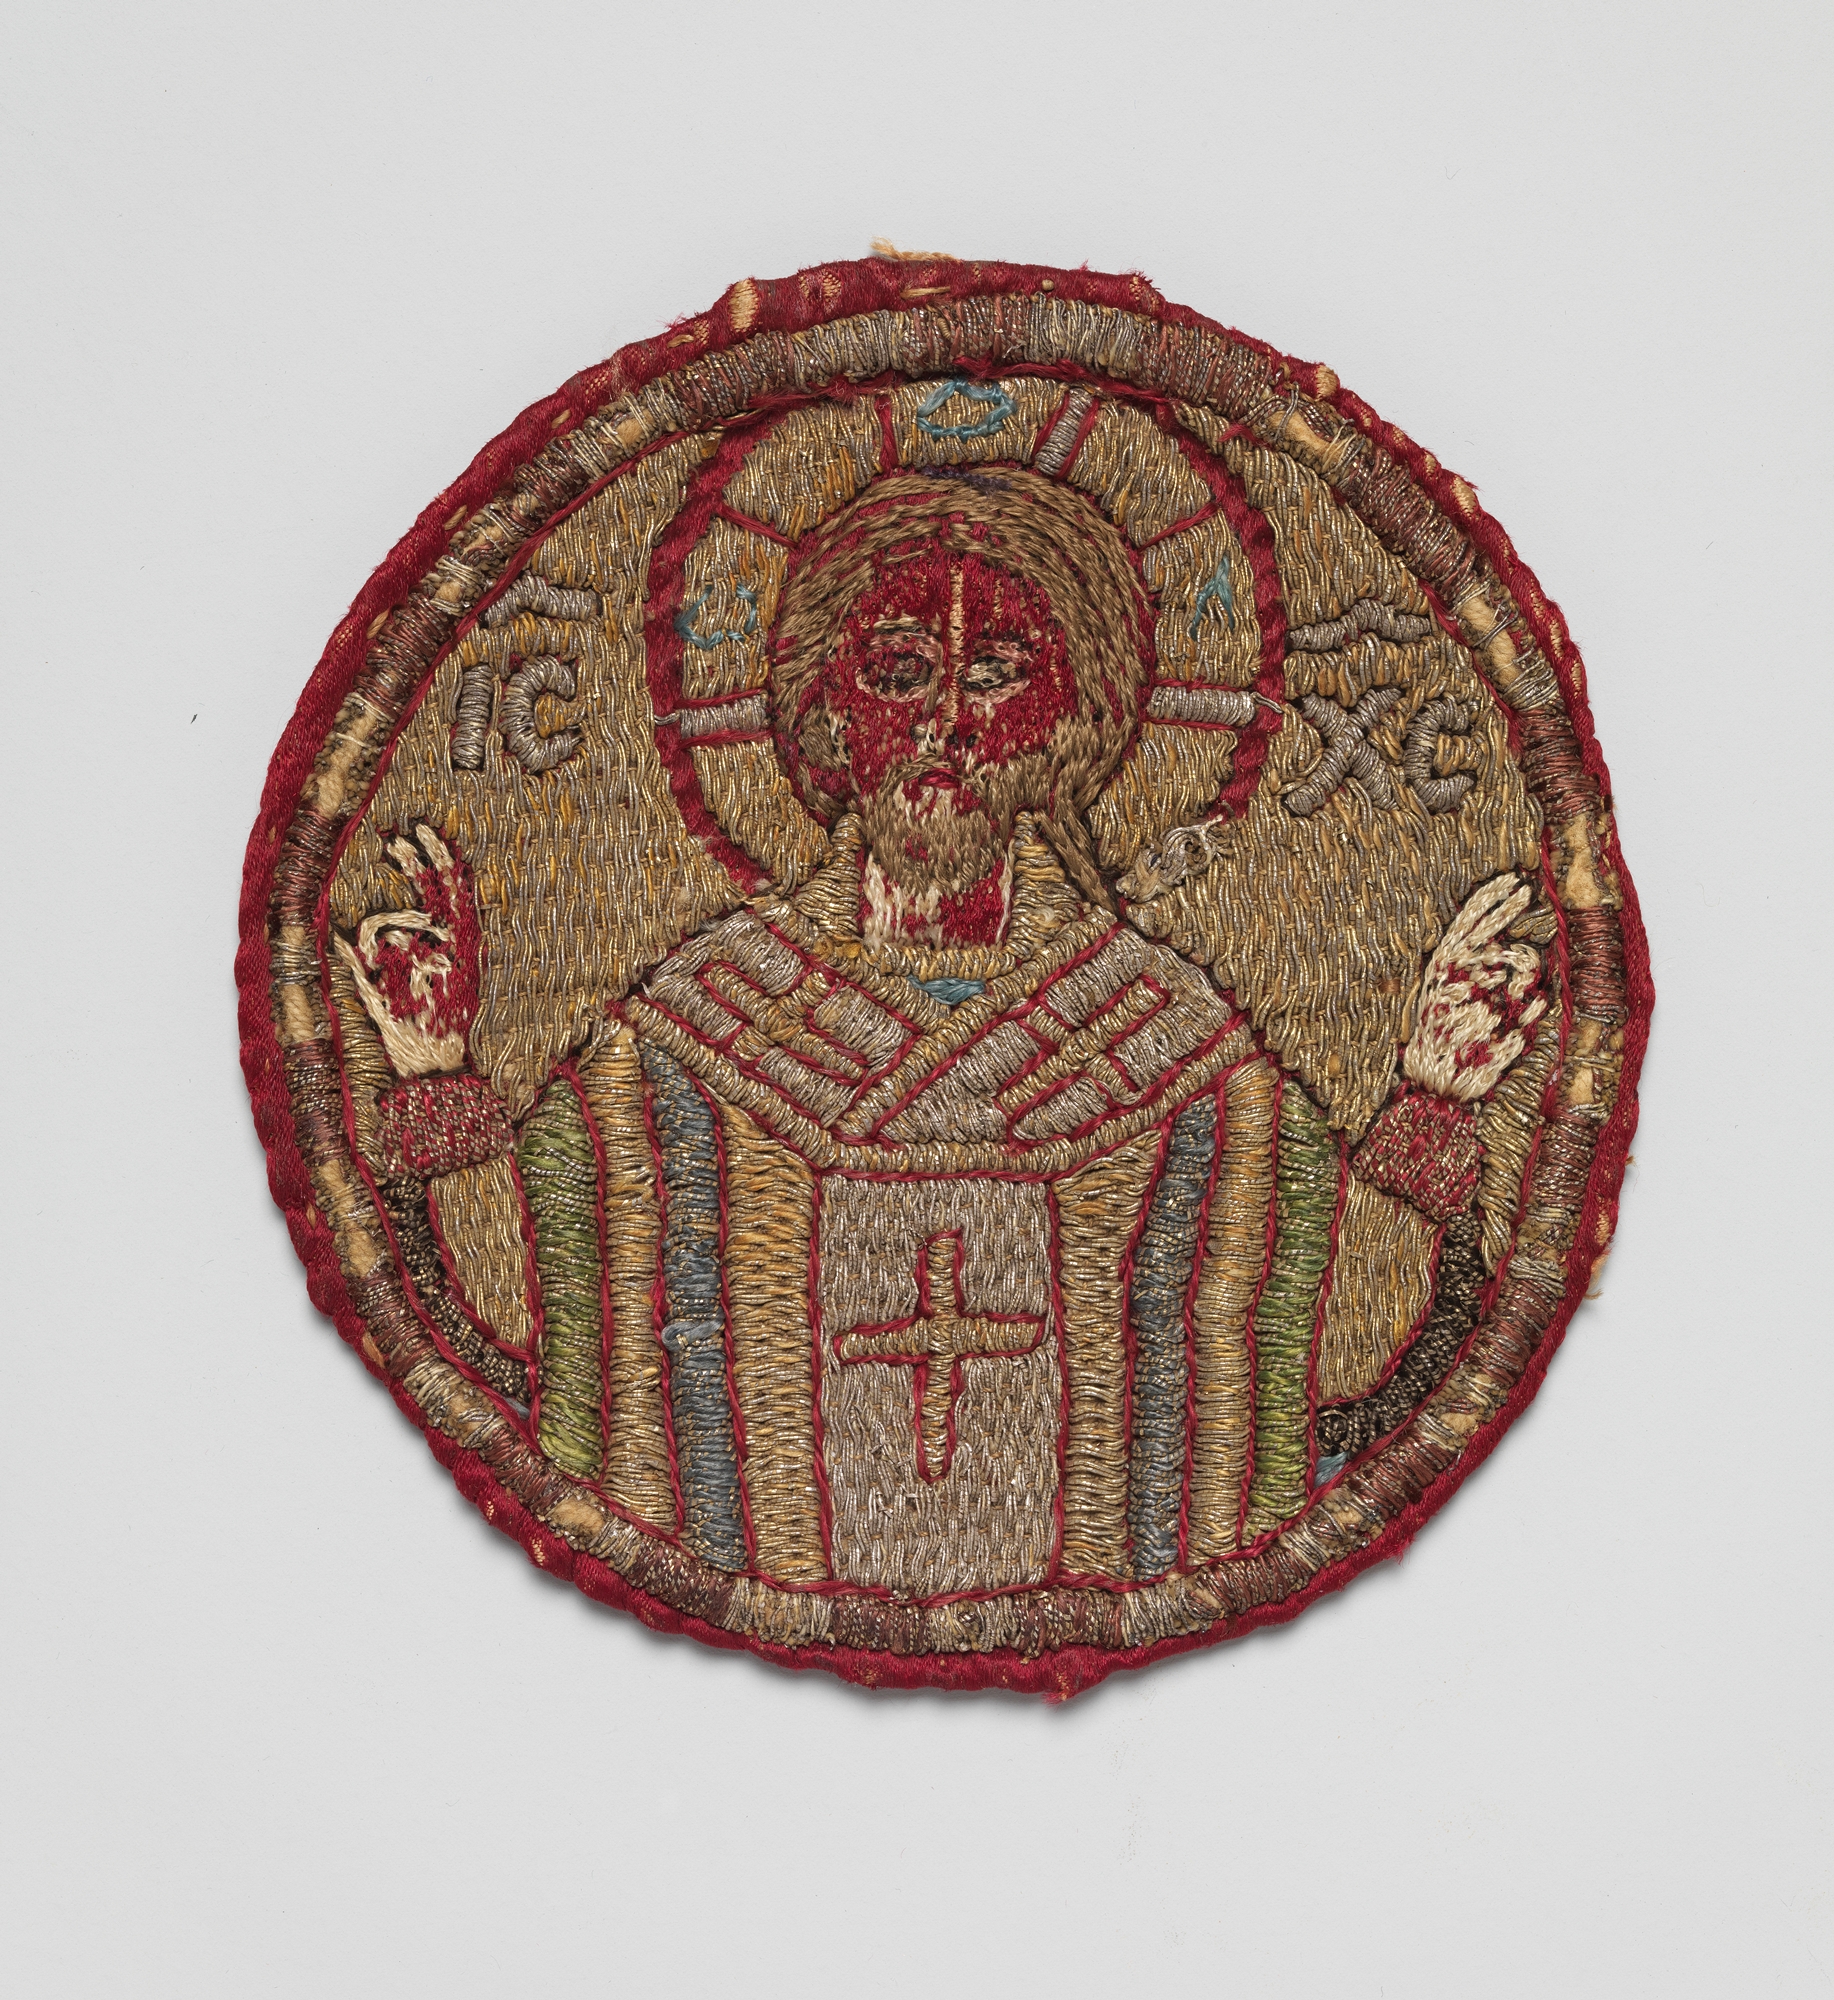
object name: appliqué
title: Appliqué from a Vestment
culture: greek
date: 1601-1800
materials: silk, silver, thread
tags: christ